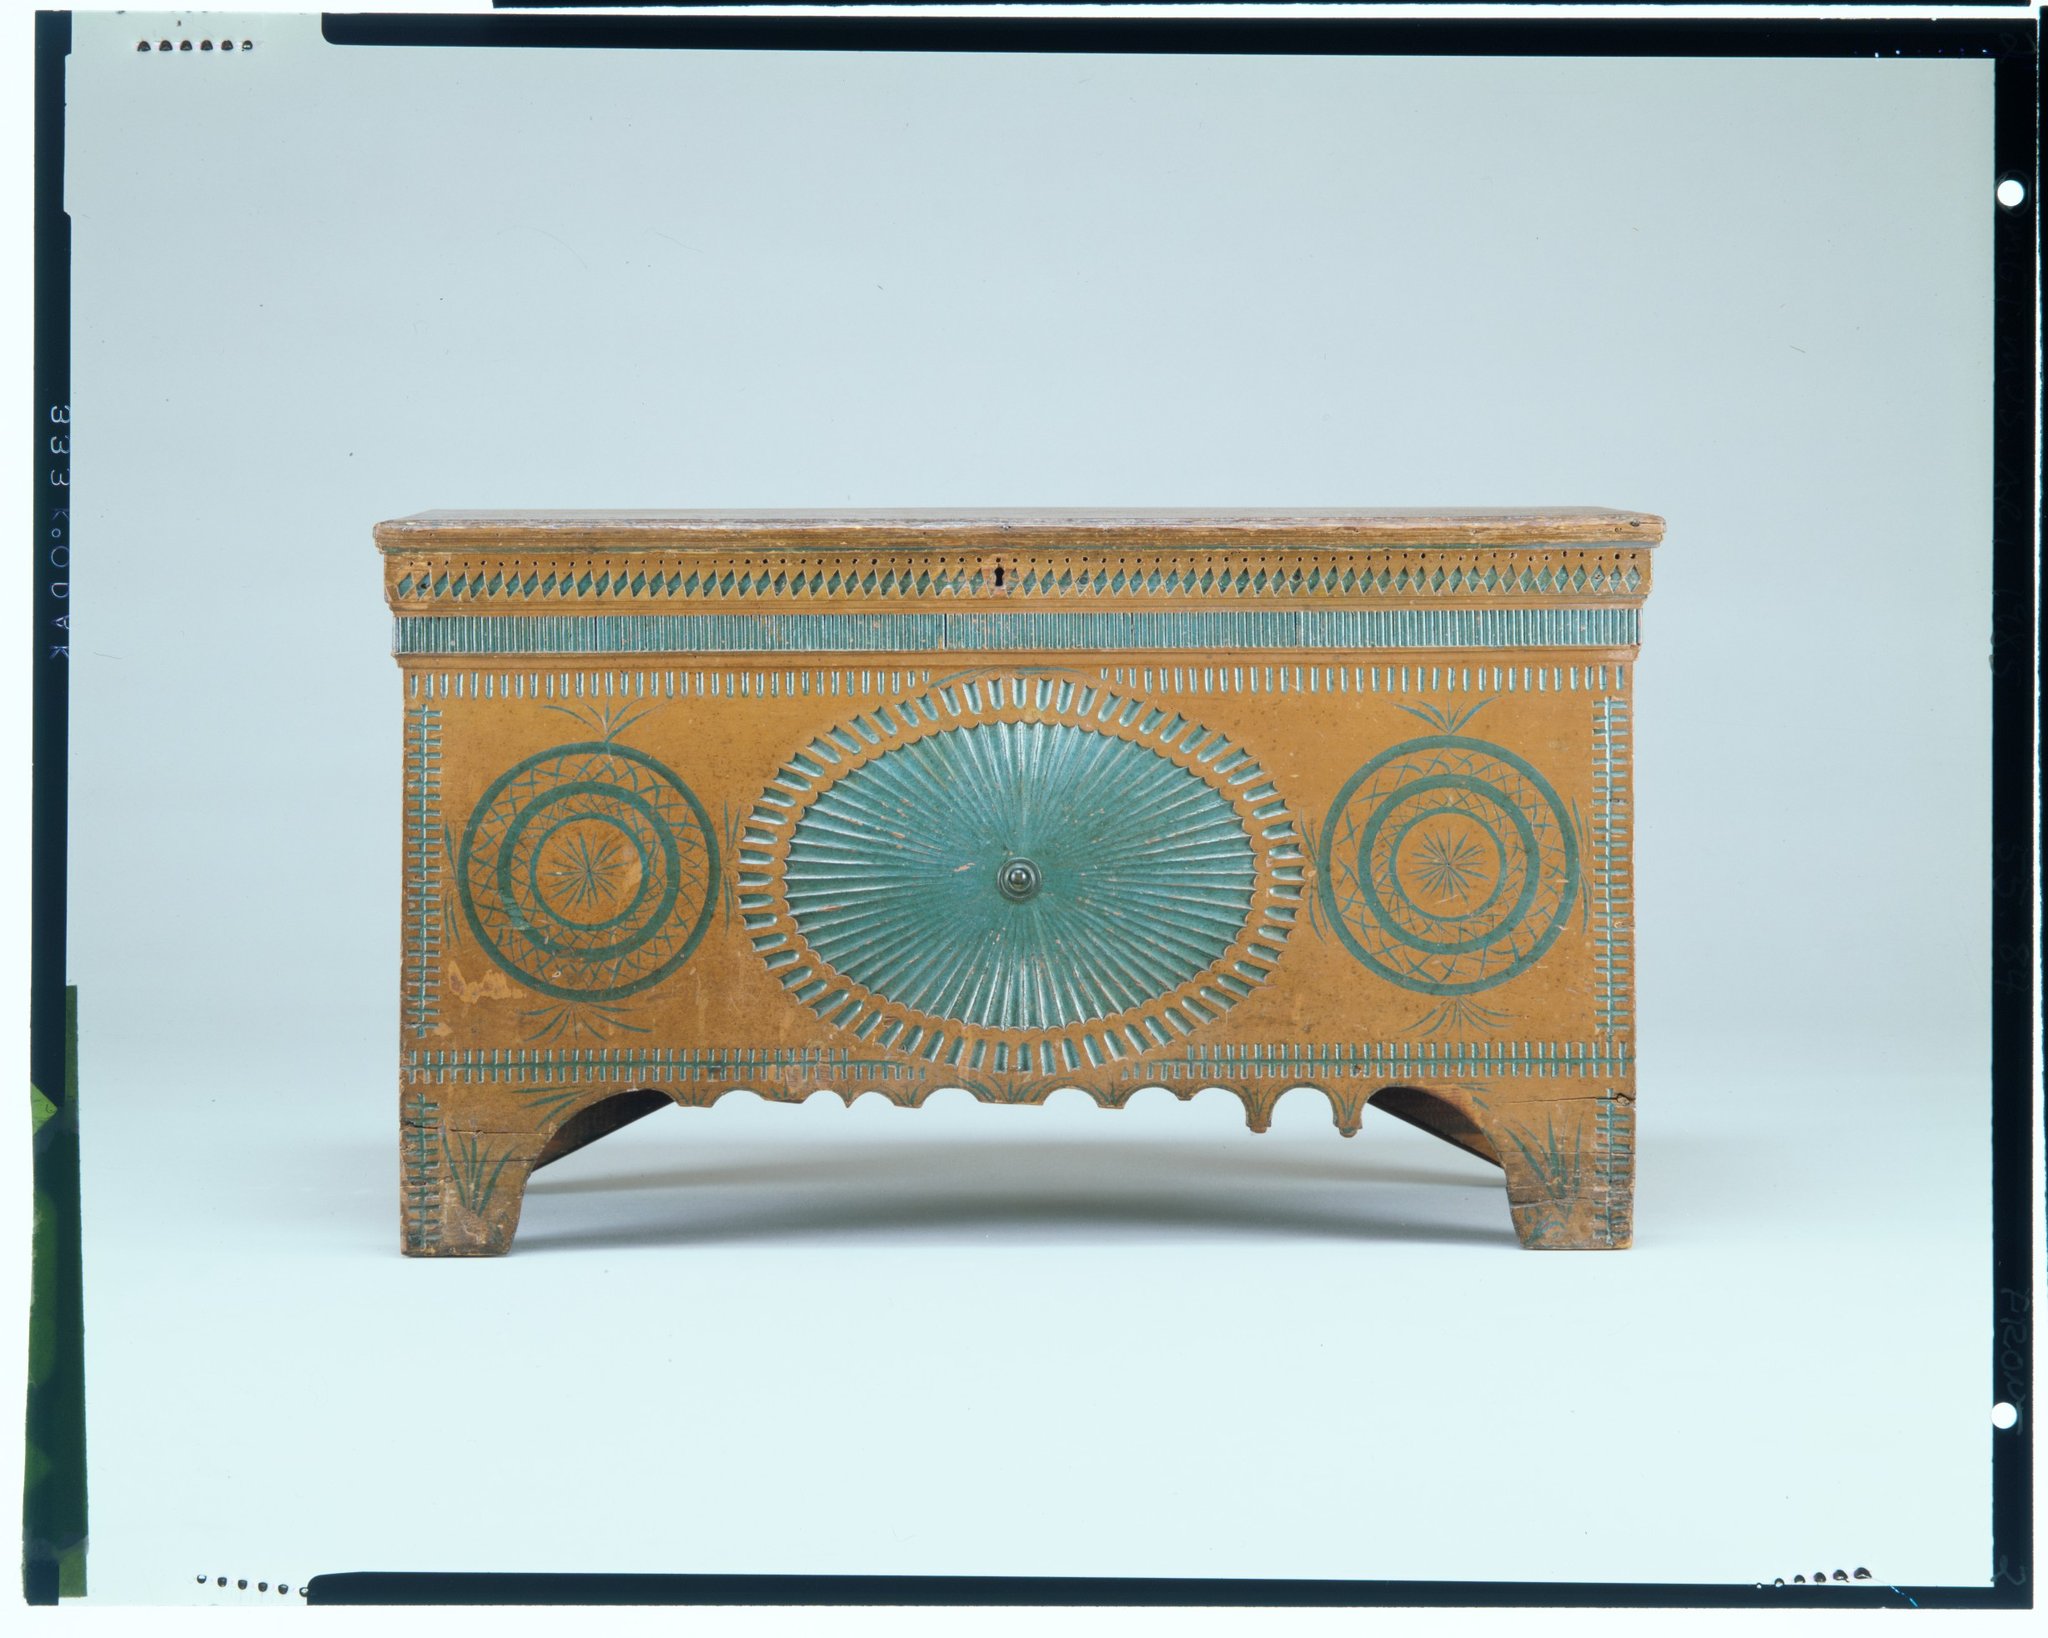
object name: chest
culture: american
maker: nehemiah randall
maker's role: maker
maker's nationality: american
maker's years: 1770-1850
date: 1800-1820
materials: wood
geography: united states